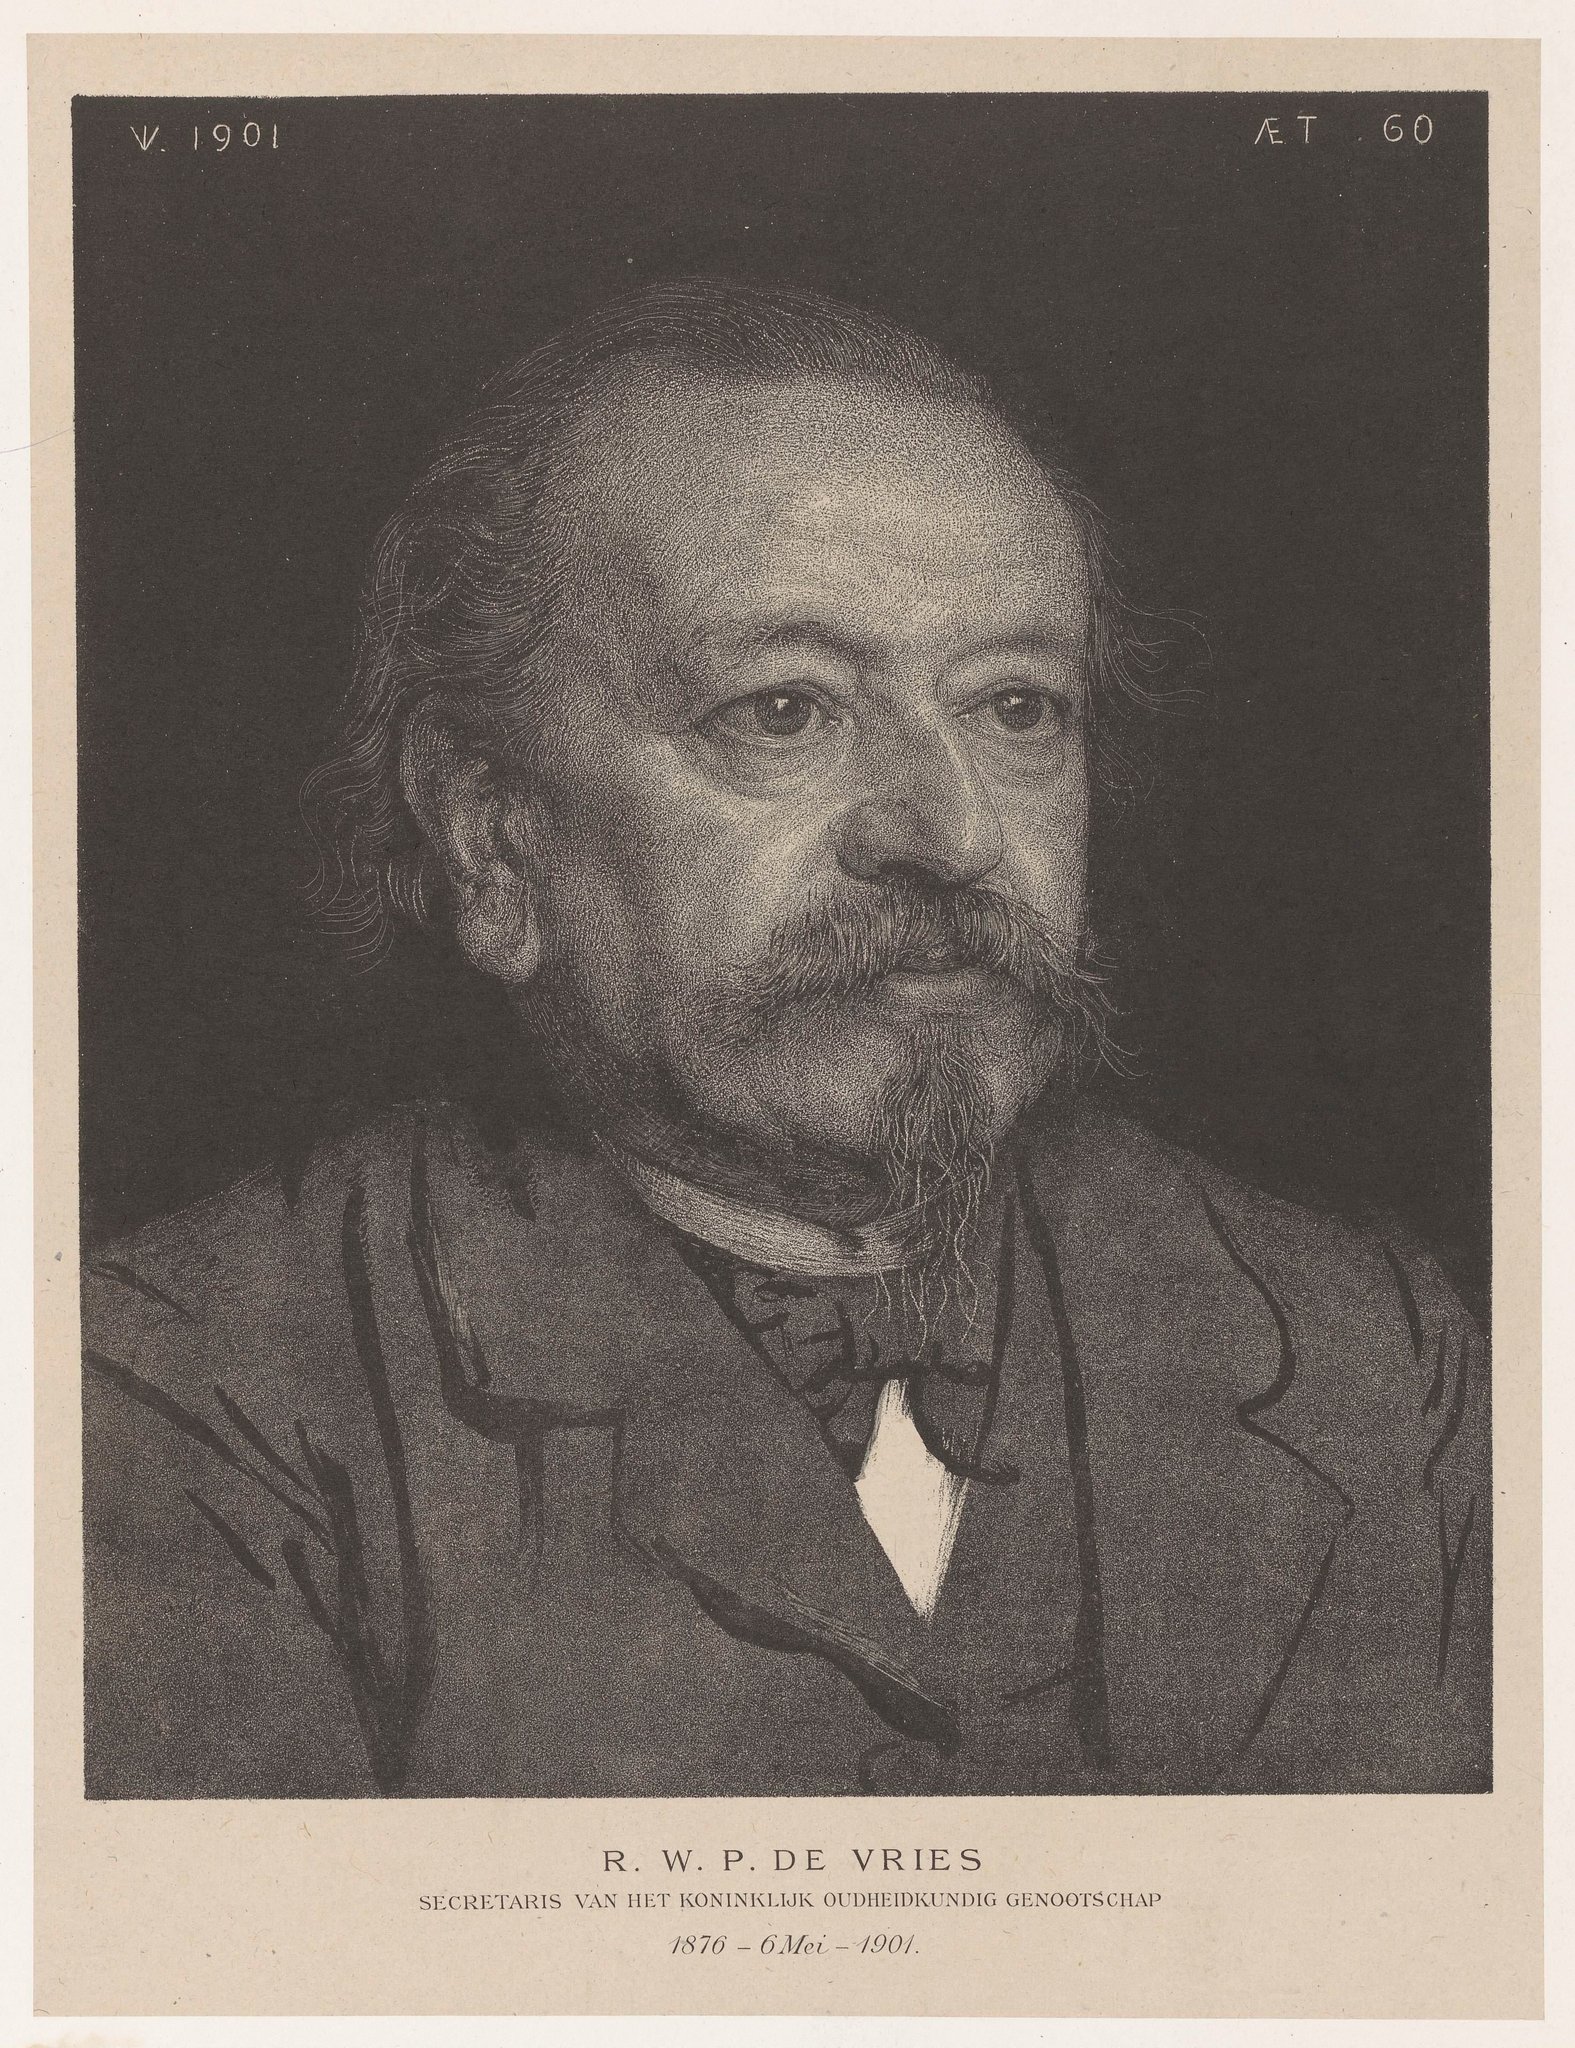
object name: print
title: Portret van Reinier Willem Petrus de Vries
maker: jan veth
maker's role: designer, draughtsman, painter, print maker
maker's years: 1864-1925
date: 1901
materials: paper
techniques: lithograph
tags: amsterdam, auctioneer, publisher, reinier willem petrus de vries (1841-1919)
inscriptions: collector's mark: Lugt 4779, collector's mark: Lugt 2228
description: Portret van Reinier Willem Petrus de Vries, veilinghouder, boekhandelaar, verzamelaar en secretaris van het Koninklijk Oudheidkundig Genootschap.